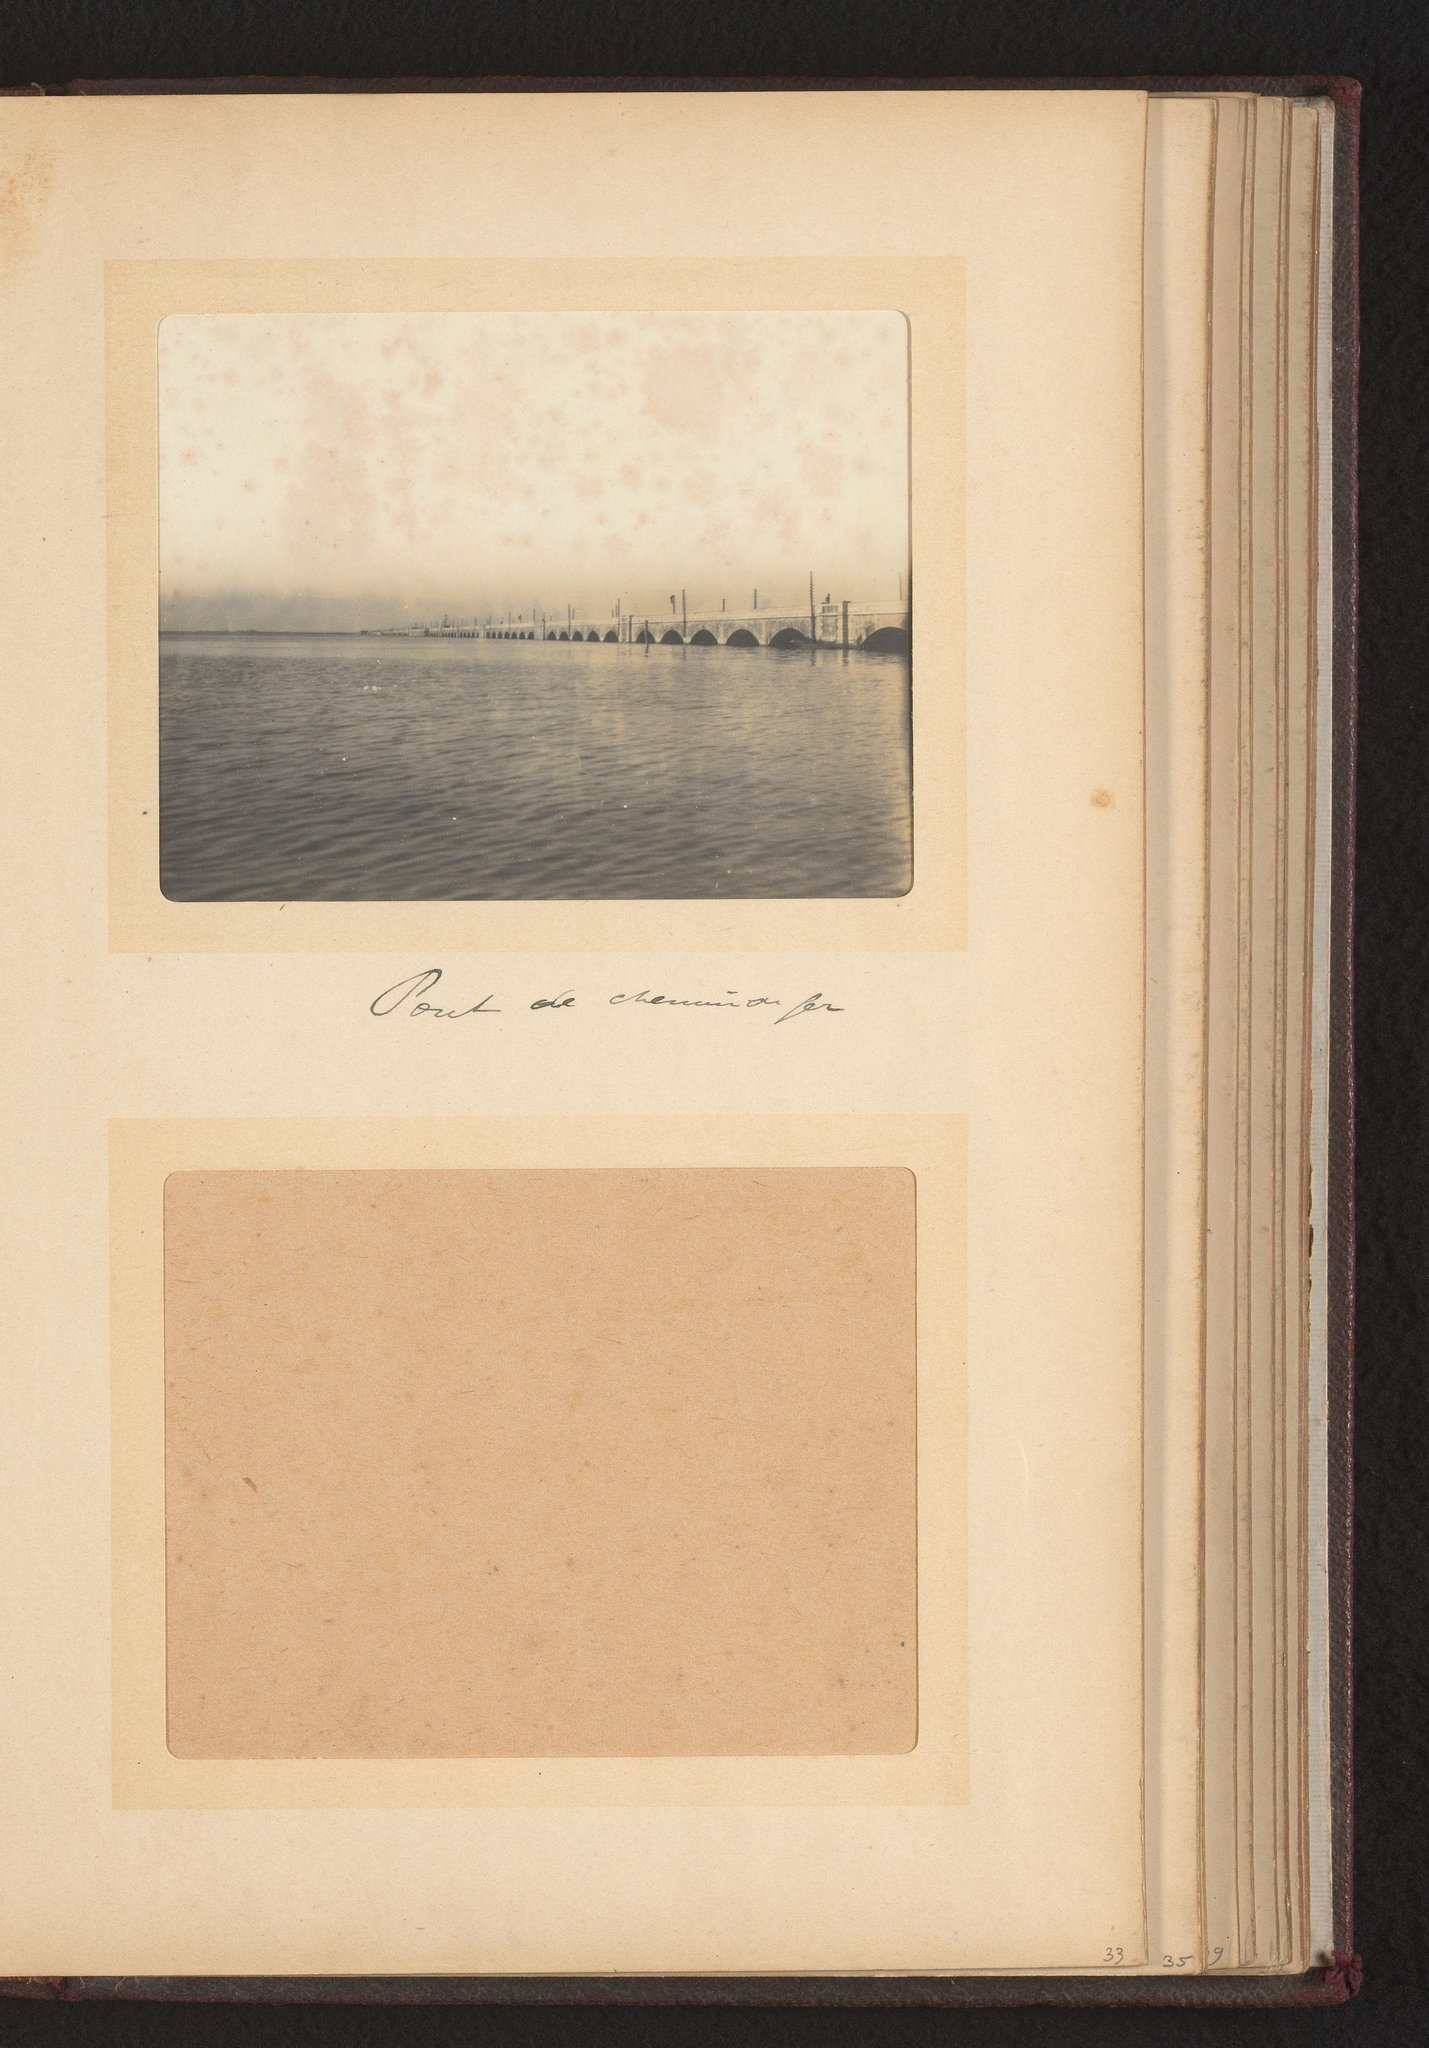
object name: album leaf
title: Spoorbrug Ponte della Libertà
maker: Anonymous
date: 1895-1905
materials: cardboard, photographic support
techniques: gelatin silver print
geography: venice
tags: tourism, railway, tramway; rack railway, bridge, venice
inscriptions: inscription: ‘Pont de chemin fer’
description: Albumblad met een foto in Venetië, en een leeg vakje. Onderdeel van een fotoalbum van een reis door Italië, ca. 1900.